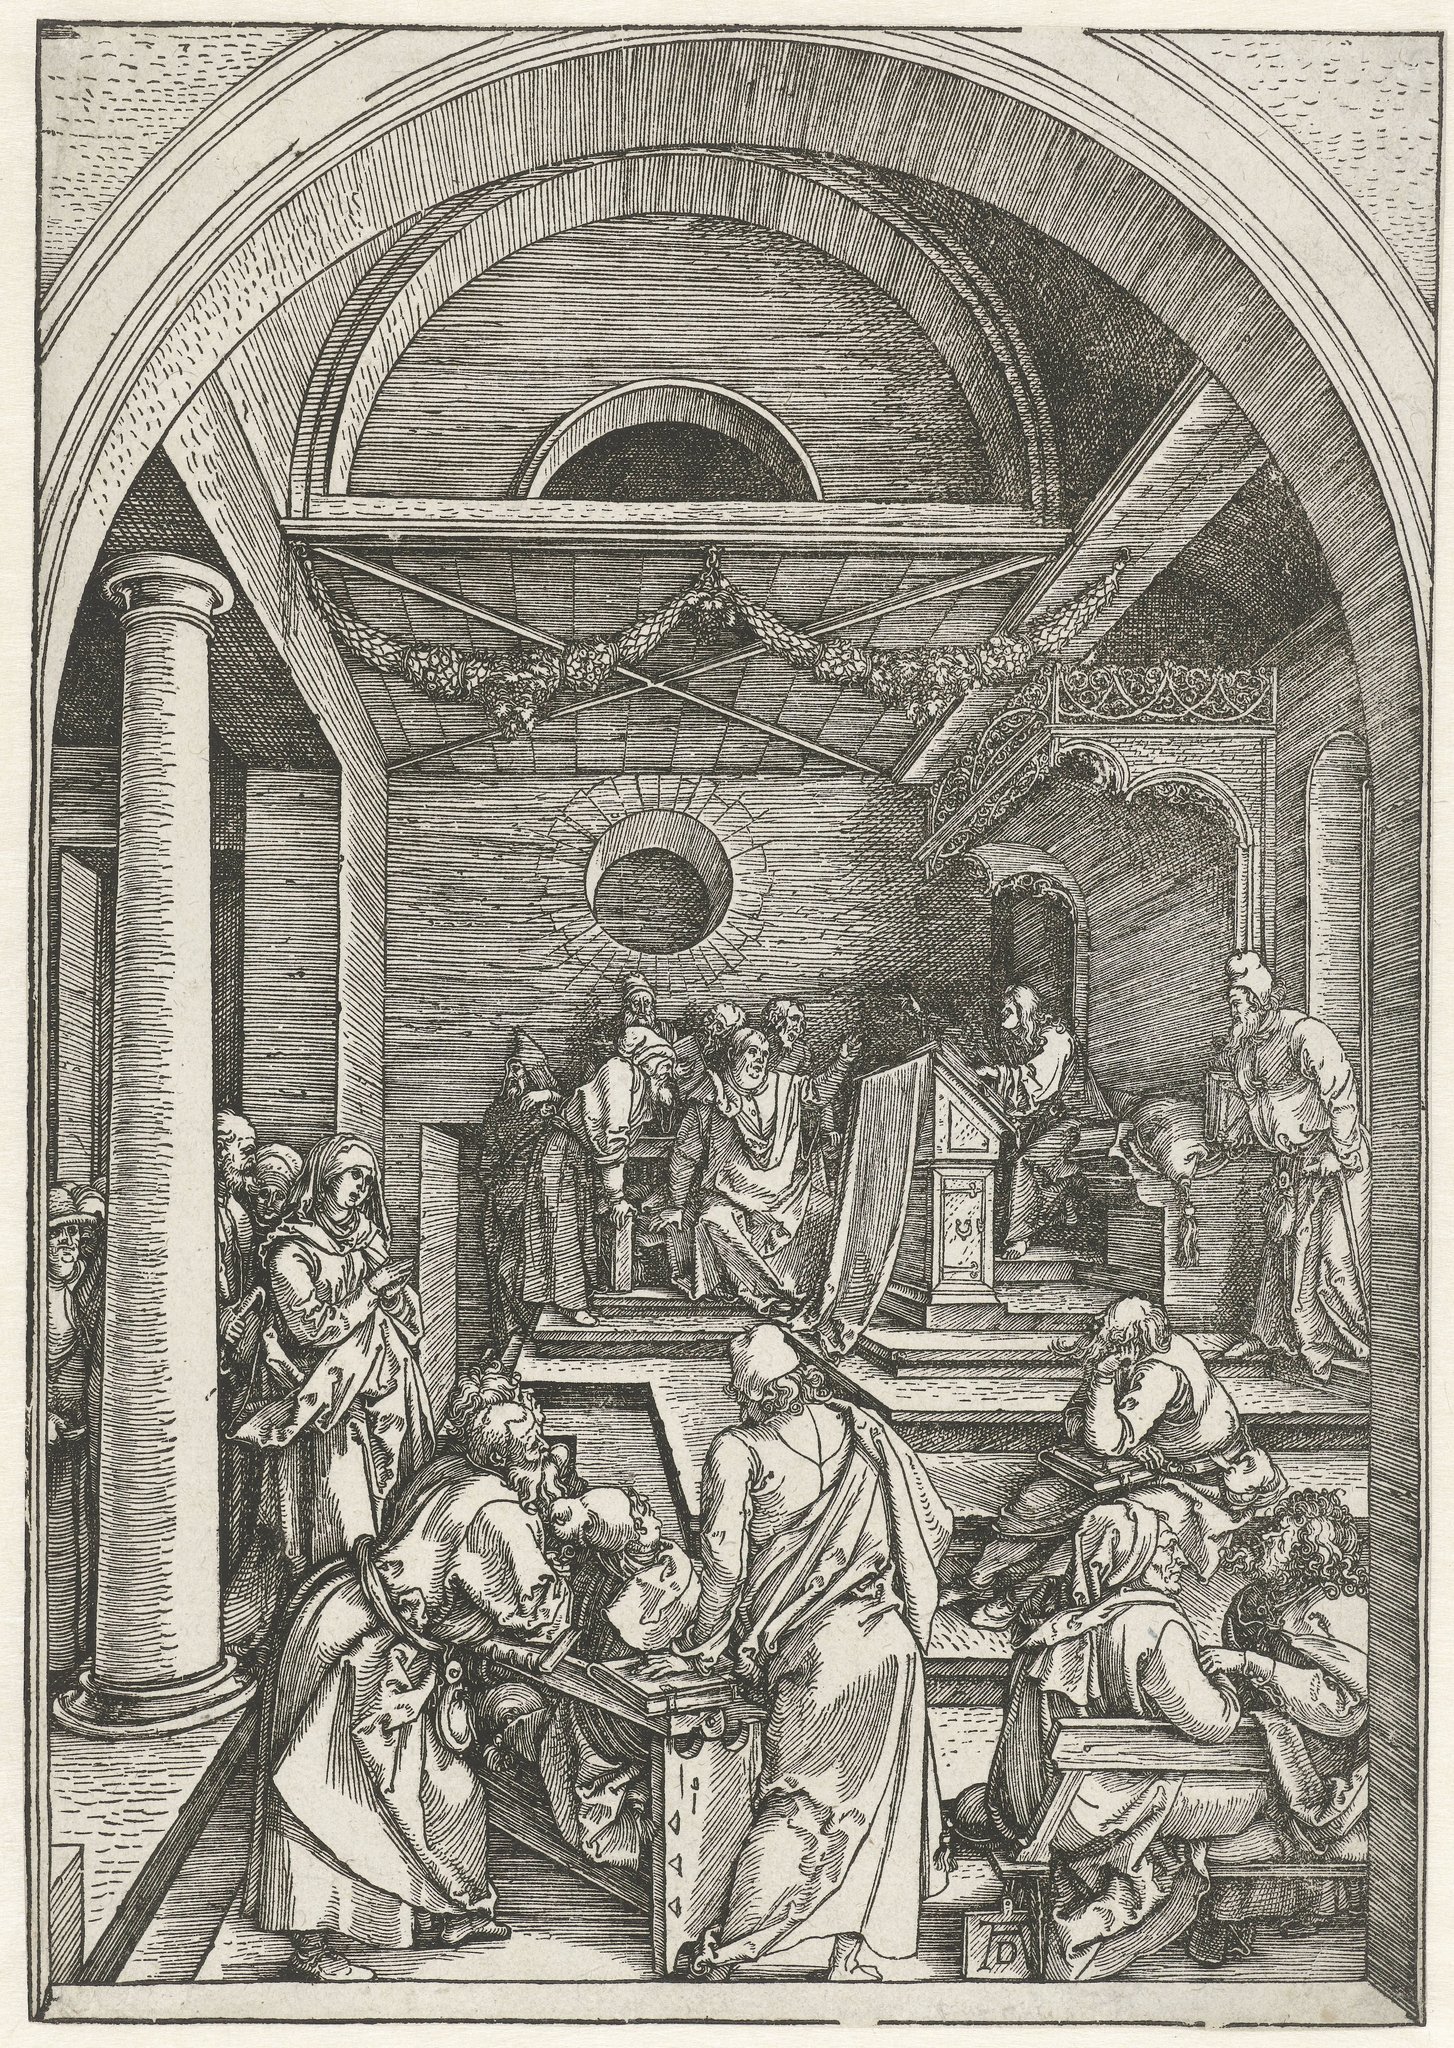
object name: print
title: Leven van Maria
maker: albrecht dürer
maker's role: draughtsman, painter, print maker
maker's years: 1471-1528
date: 1501-1505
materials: paper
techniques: woodcut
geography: nuremberg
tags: christ's dispute with the doctors in the temple; he counts his arguments on his fingers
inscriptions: collector's mark: Lugt 240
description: Op een verhoging zit de jonge Christus achter een lezenaar. Hij discussieert met een aantal schriftgeleerden, terwijl een groep mensen luistert. links bij een pilaar staan Maria en Jozef. Deze prent is onderdeel van een serie van 20 prenten, bestaand uit een titelprent en 19 prenten met scènes uit het leven van Maria.